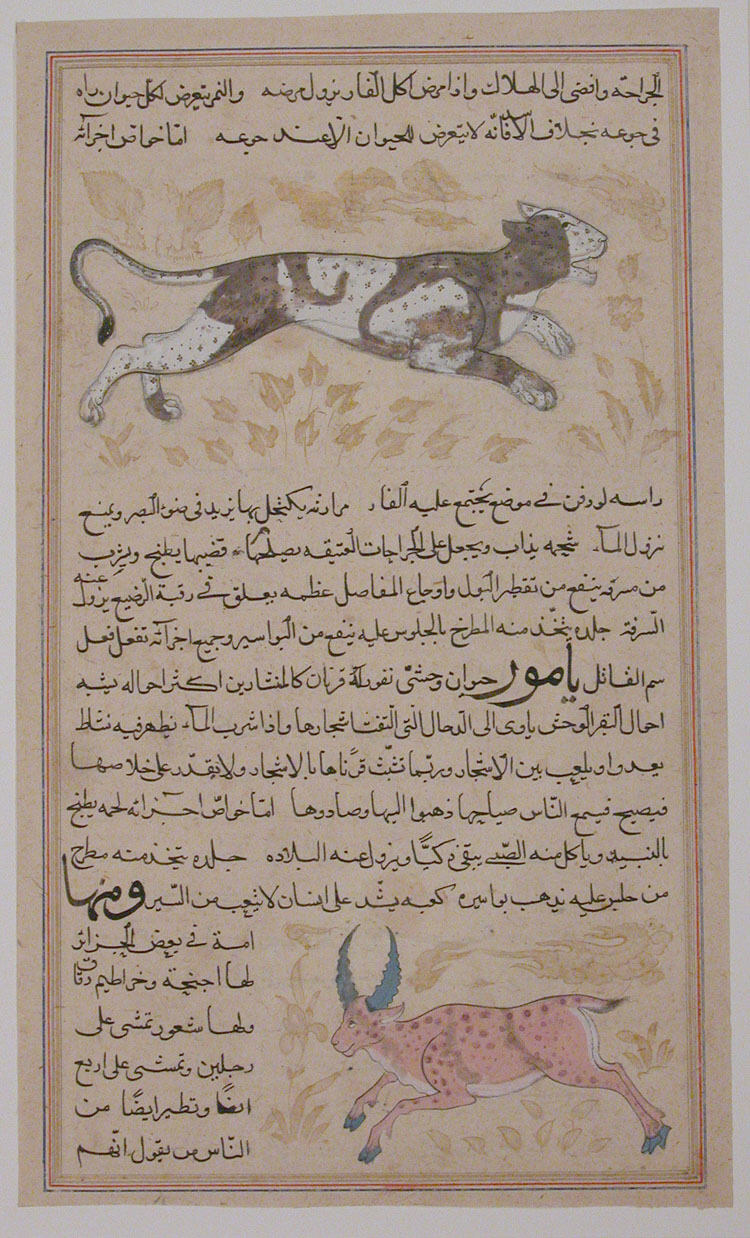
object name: folio from an illustrated manuscript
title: Folio from a `Aja'ib al-Makhluqat wa Ghara'ib al-Mawjudat (The Wonders of Creation and the Oddities of Existence)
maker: zakaria bin muhammad bin mahmud abu yahya qazwini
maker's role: author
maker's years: 1198-1283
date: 1601-1700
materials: gold, ink, paper, watercolor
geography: india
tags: animals